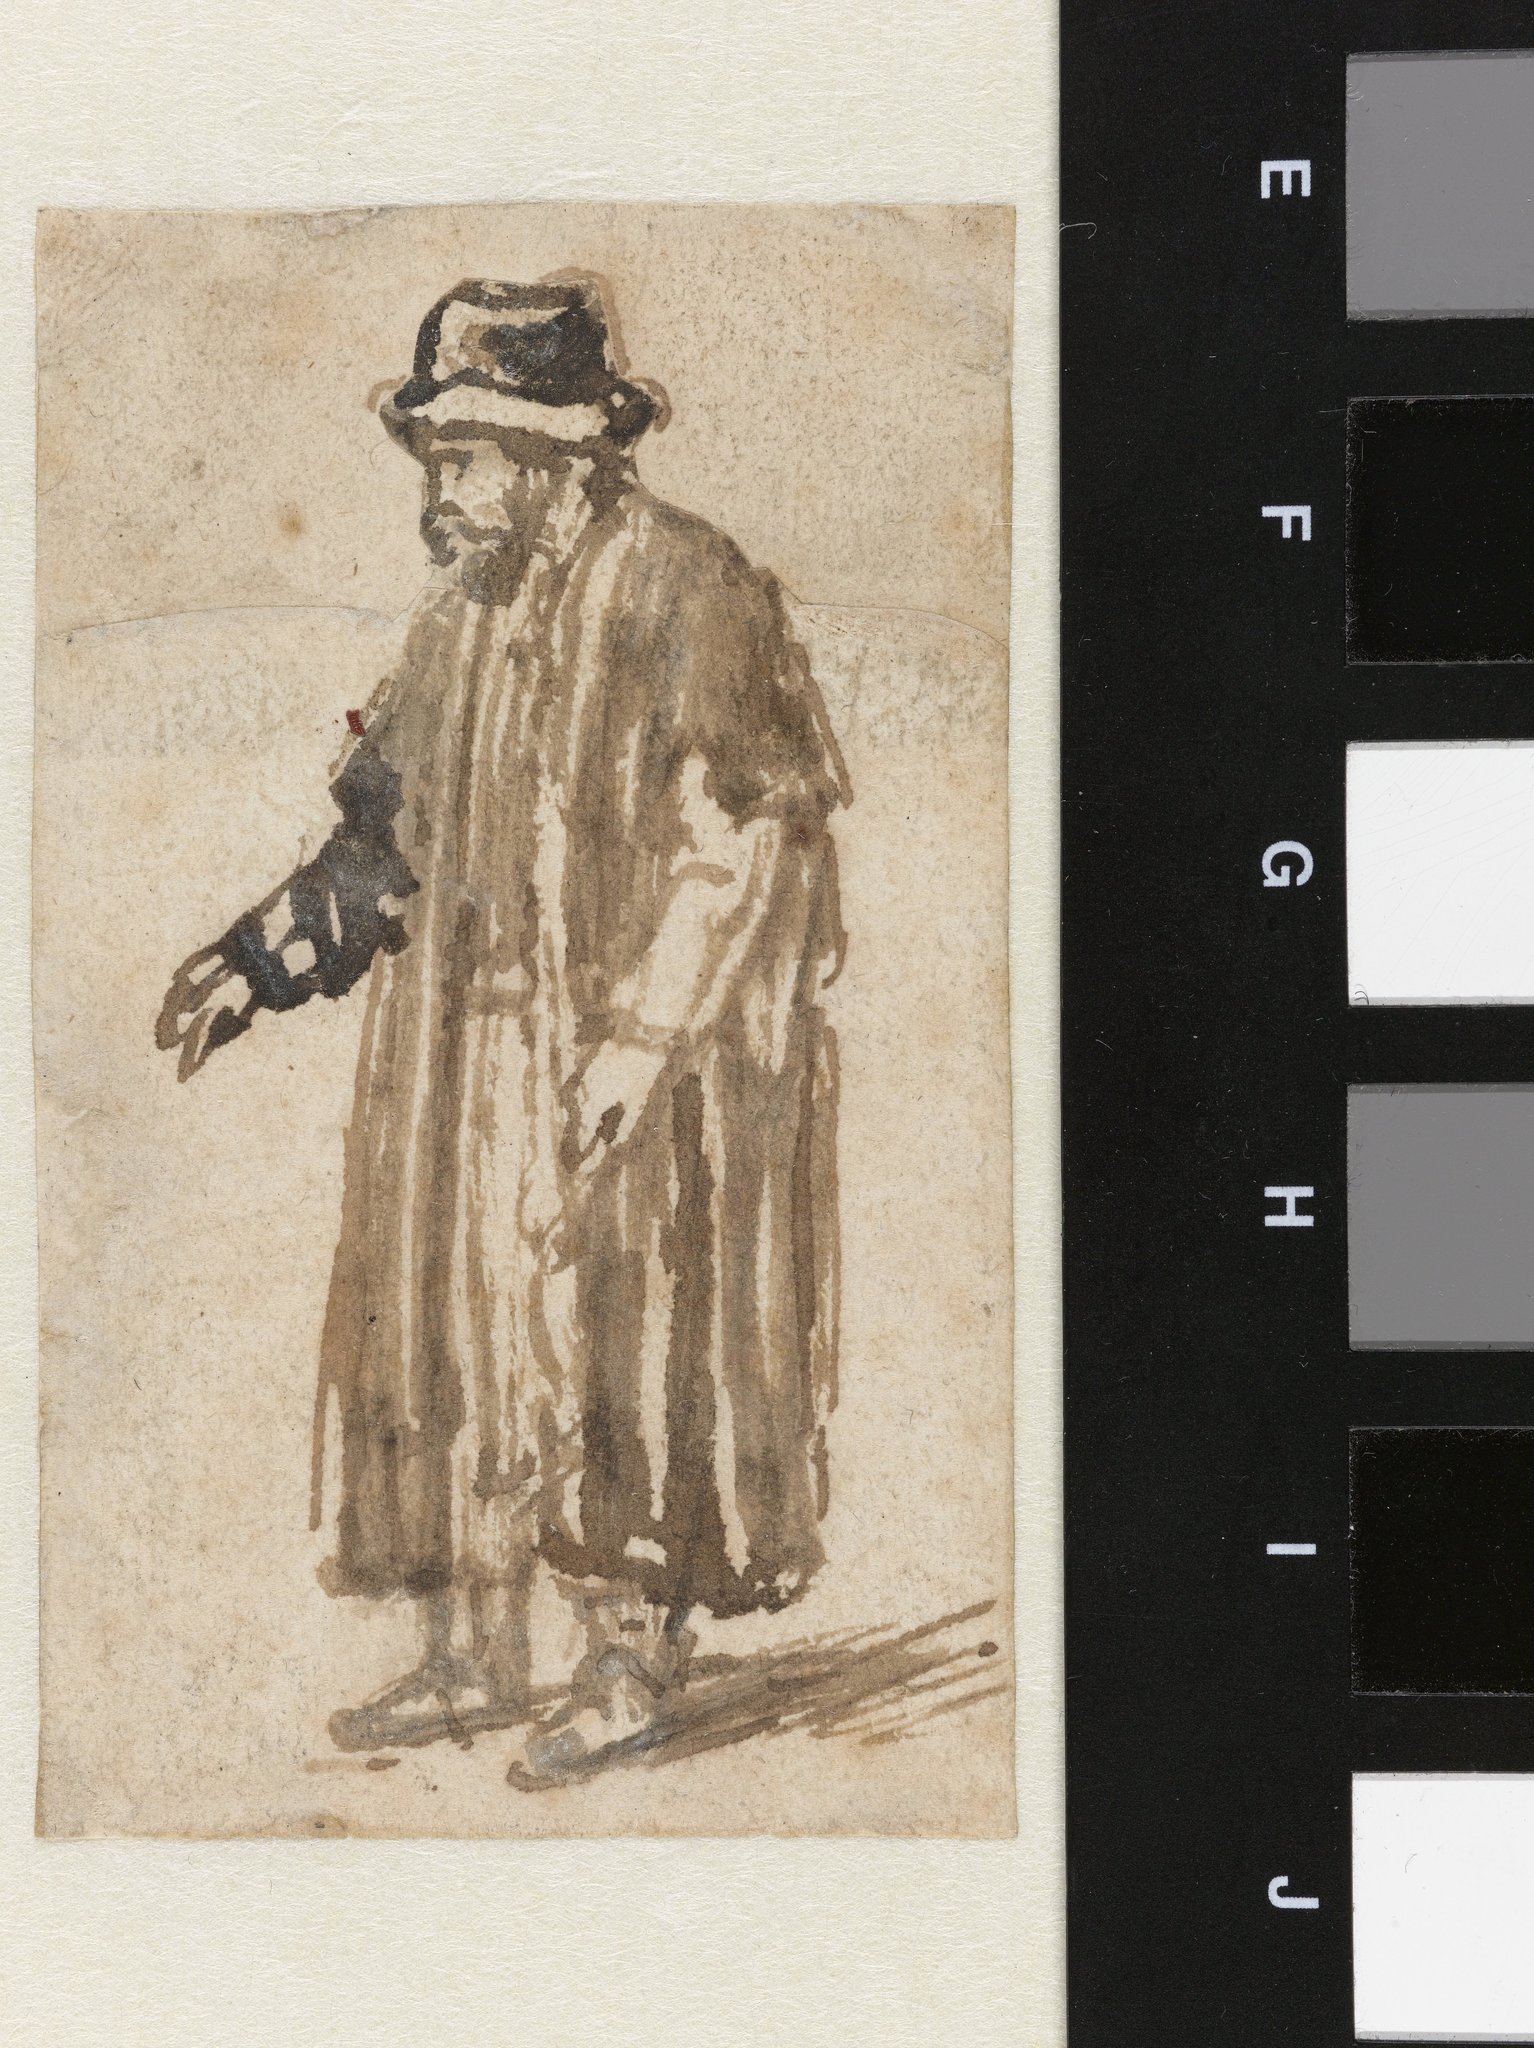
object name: drawing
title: Standing Man Seen from the Side, his Right Arm Raised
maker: willem drost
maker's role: draughtsman, painter, print maker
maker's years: 1633-1659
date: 1650-1655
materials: ink, paint, paper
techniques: brush, pen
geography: amsterdam